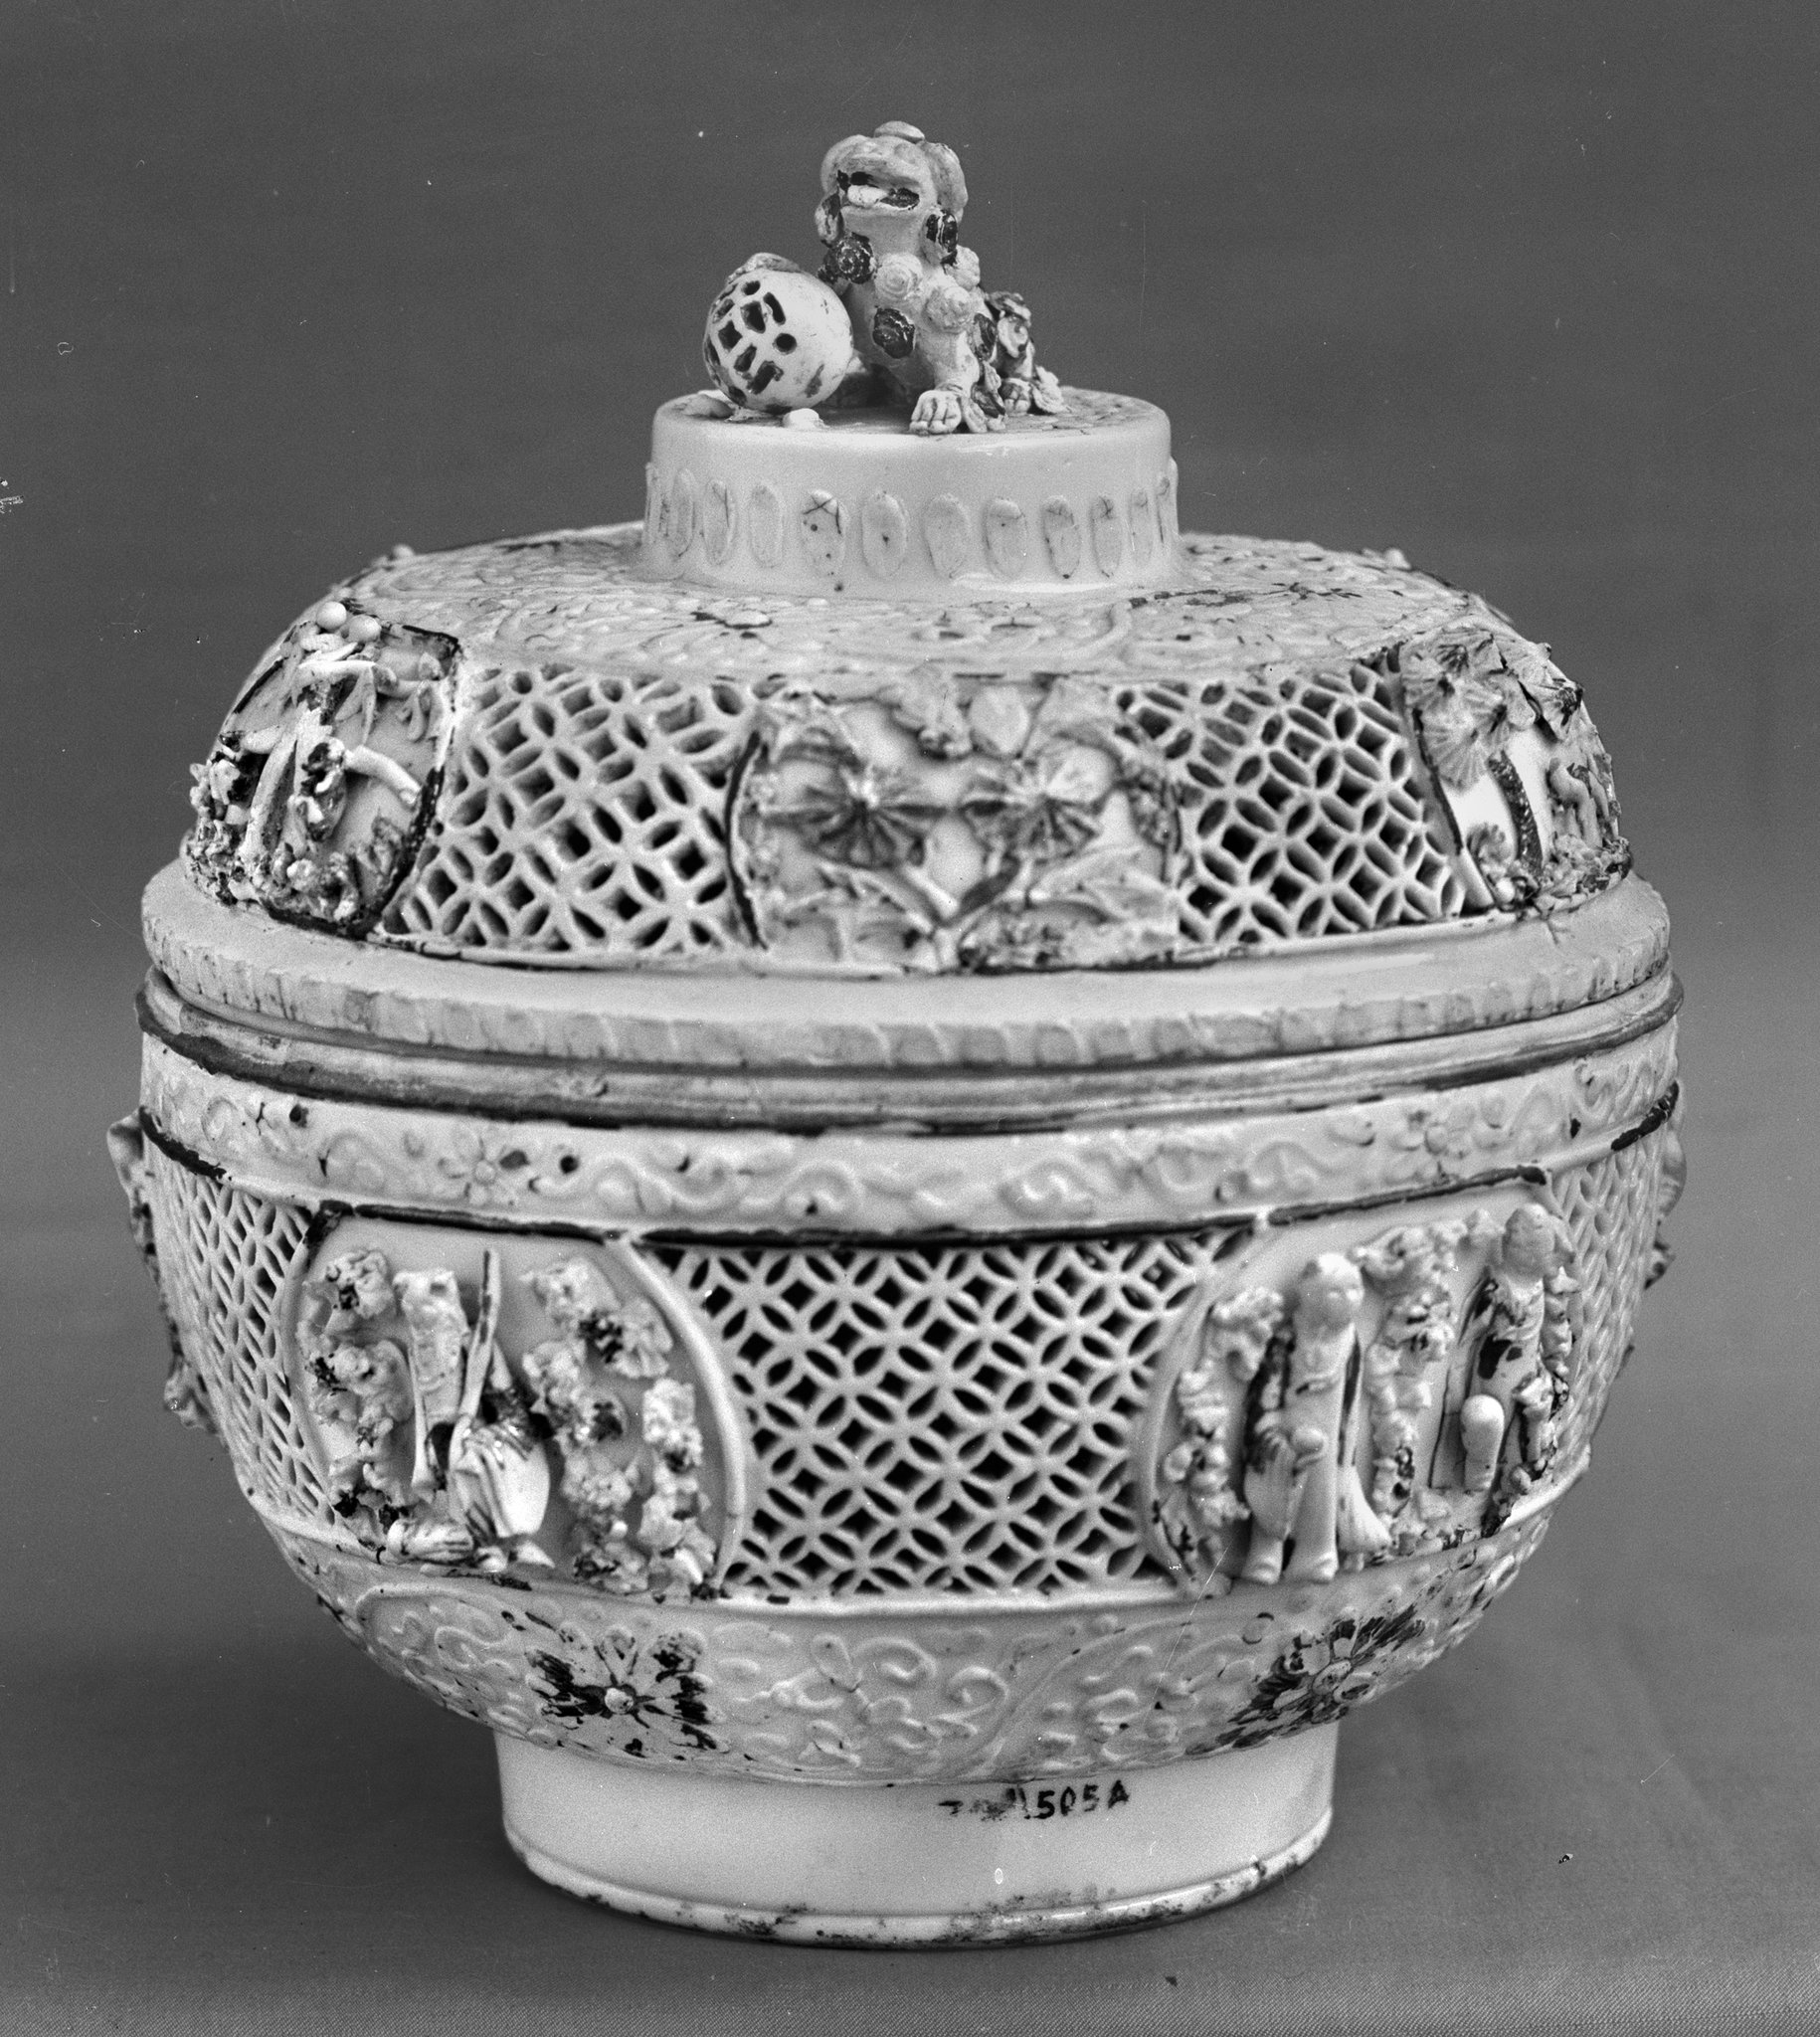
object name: covered bowl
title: Covered bowl with figures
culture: chinese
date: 1601-1700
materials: biscuit, gilt, porcelain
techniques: relief